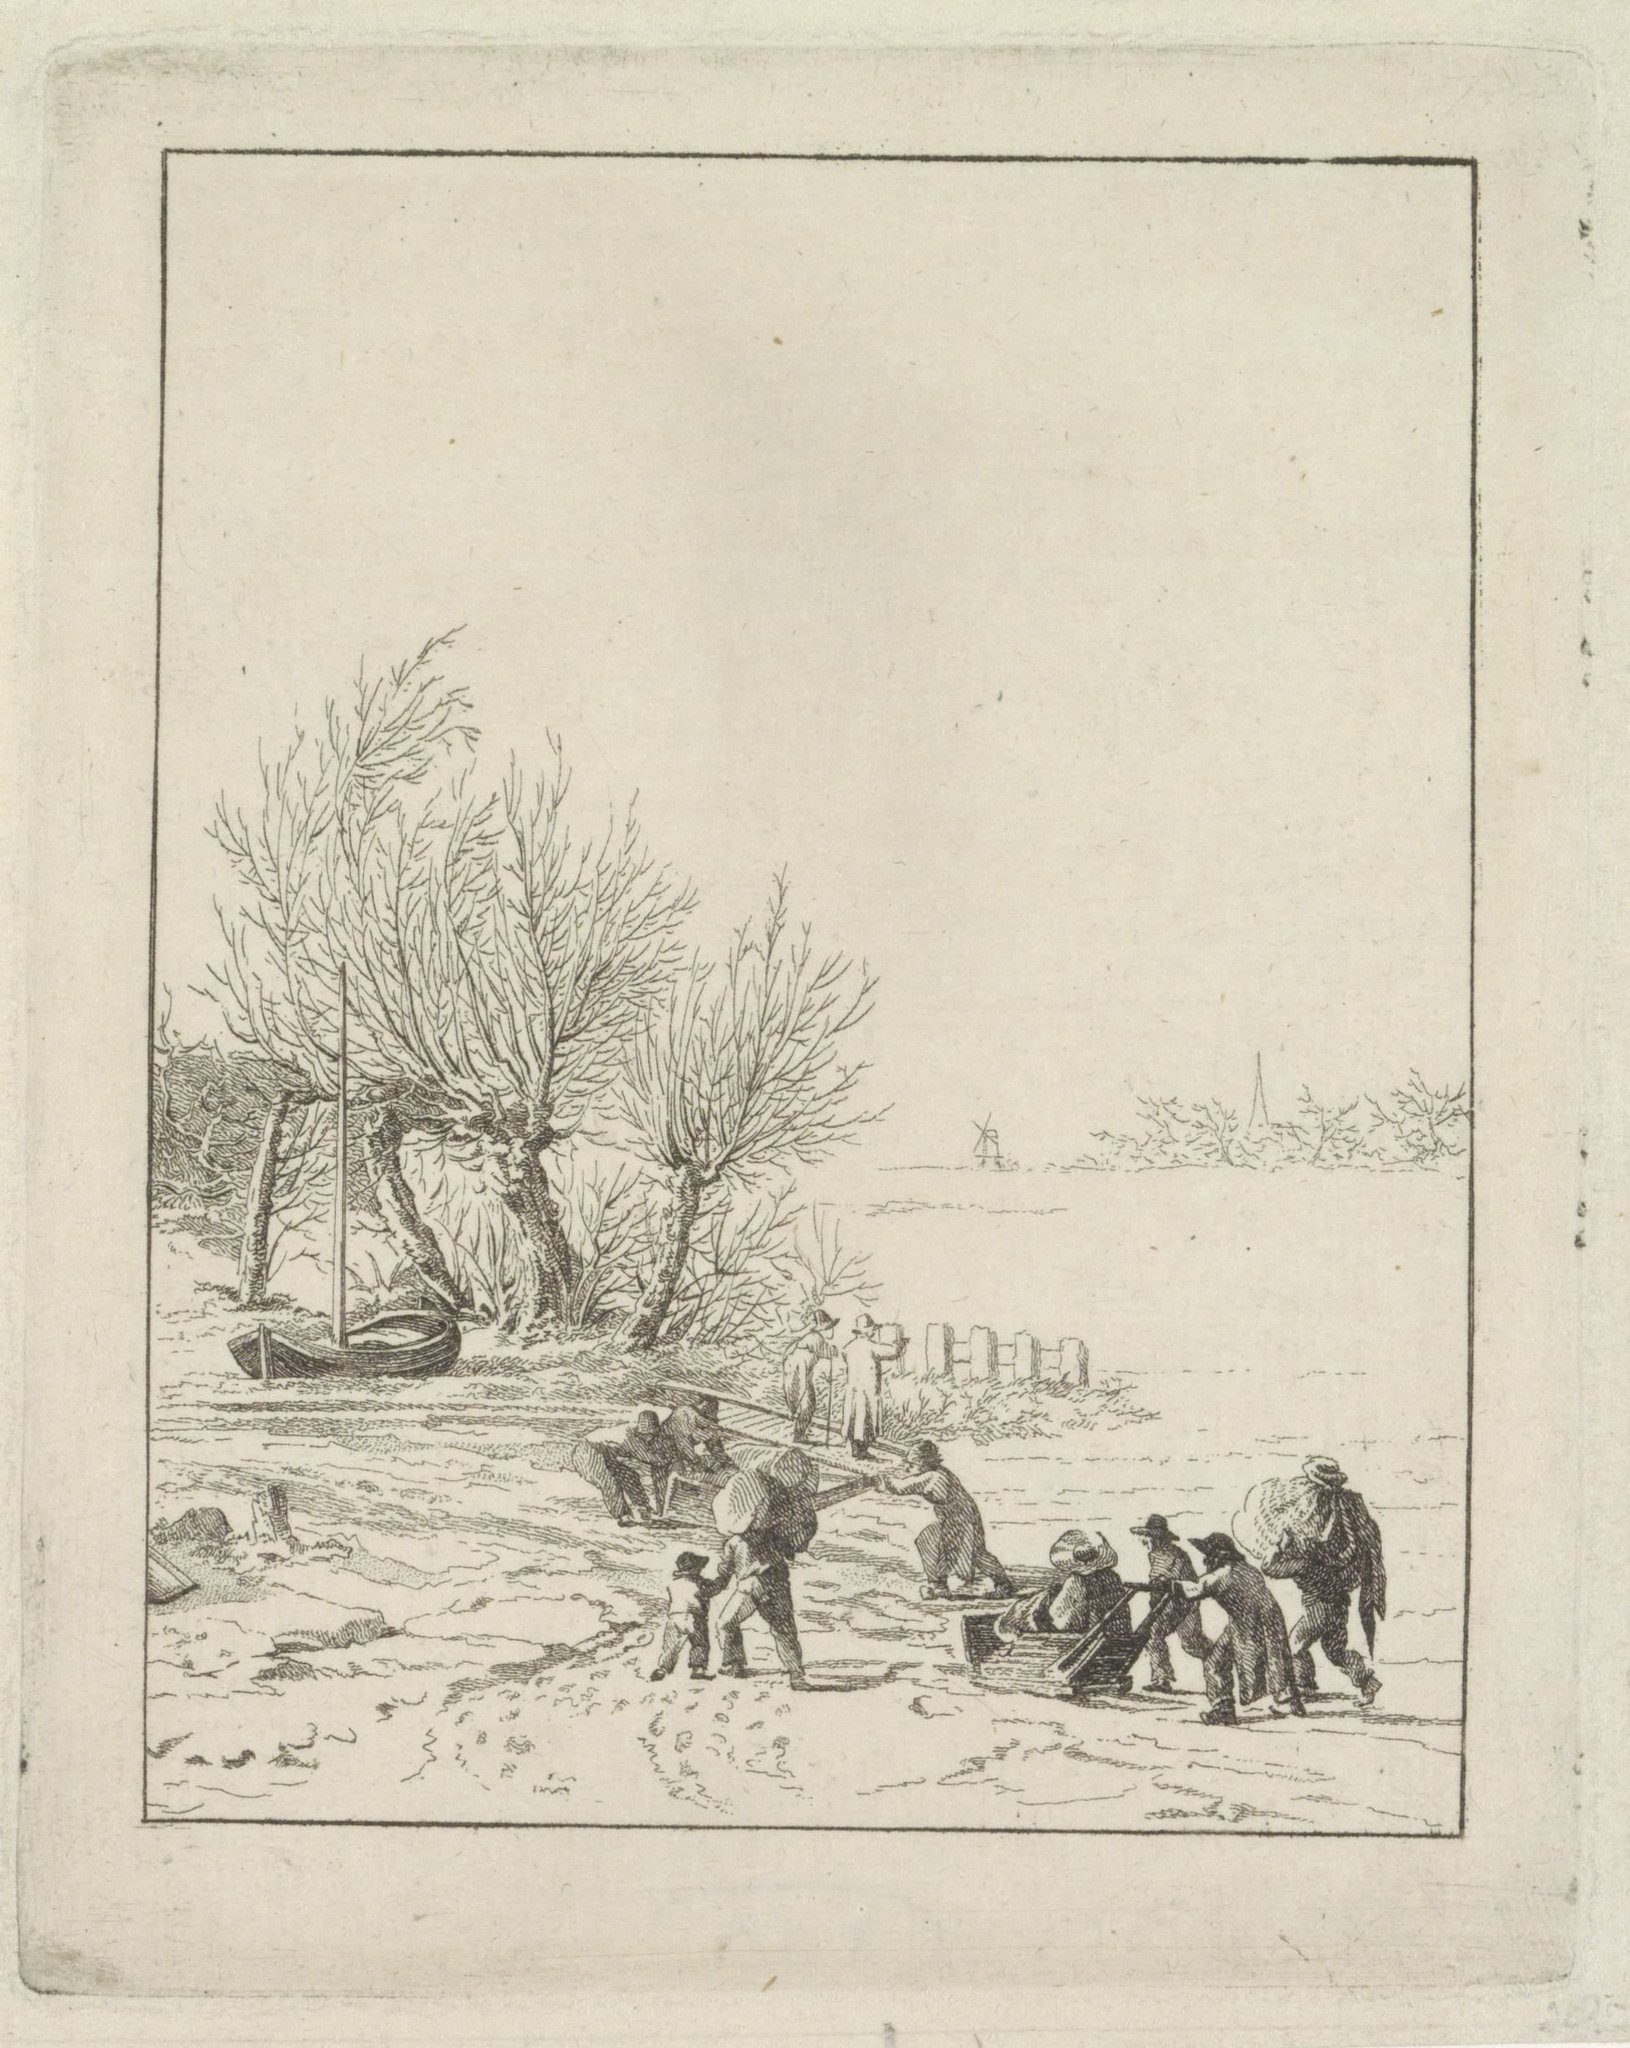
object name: print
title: Bevroren rivier met sleeënde kinderen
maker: joannes bemme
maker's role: print maker, printer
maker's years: 1775-1841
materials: paper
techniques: etching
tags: winter landscape; landscape symbolizing winter (the four seasons of the year), sliding (playing with snow and ice)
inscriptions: collector's mark: Lugt 2228